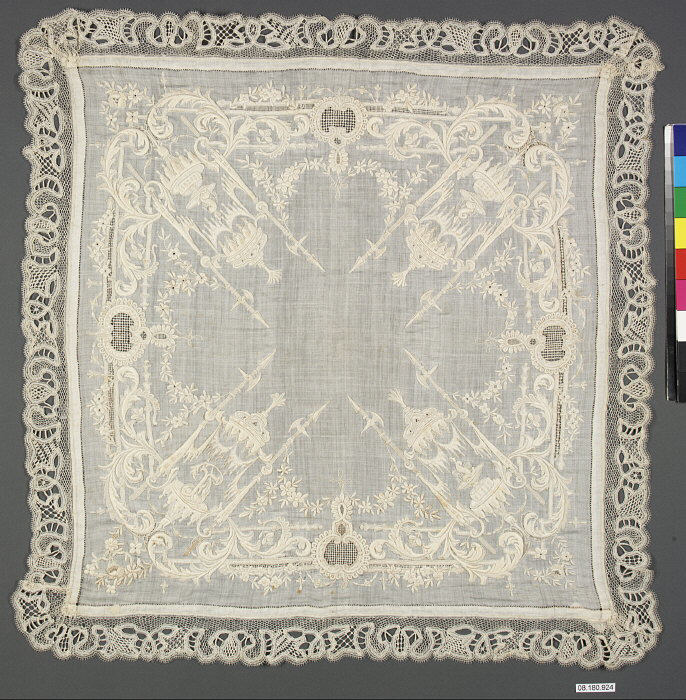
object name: handkerchief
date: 1801-1900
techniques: lace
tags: flowers